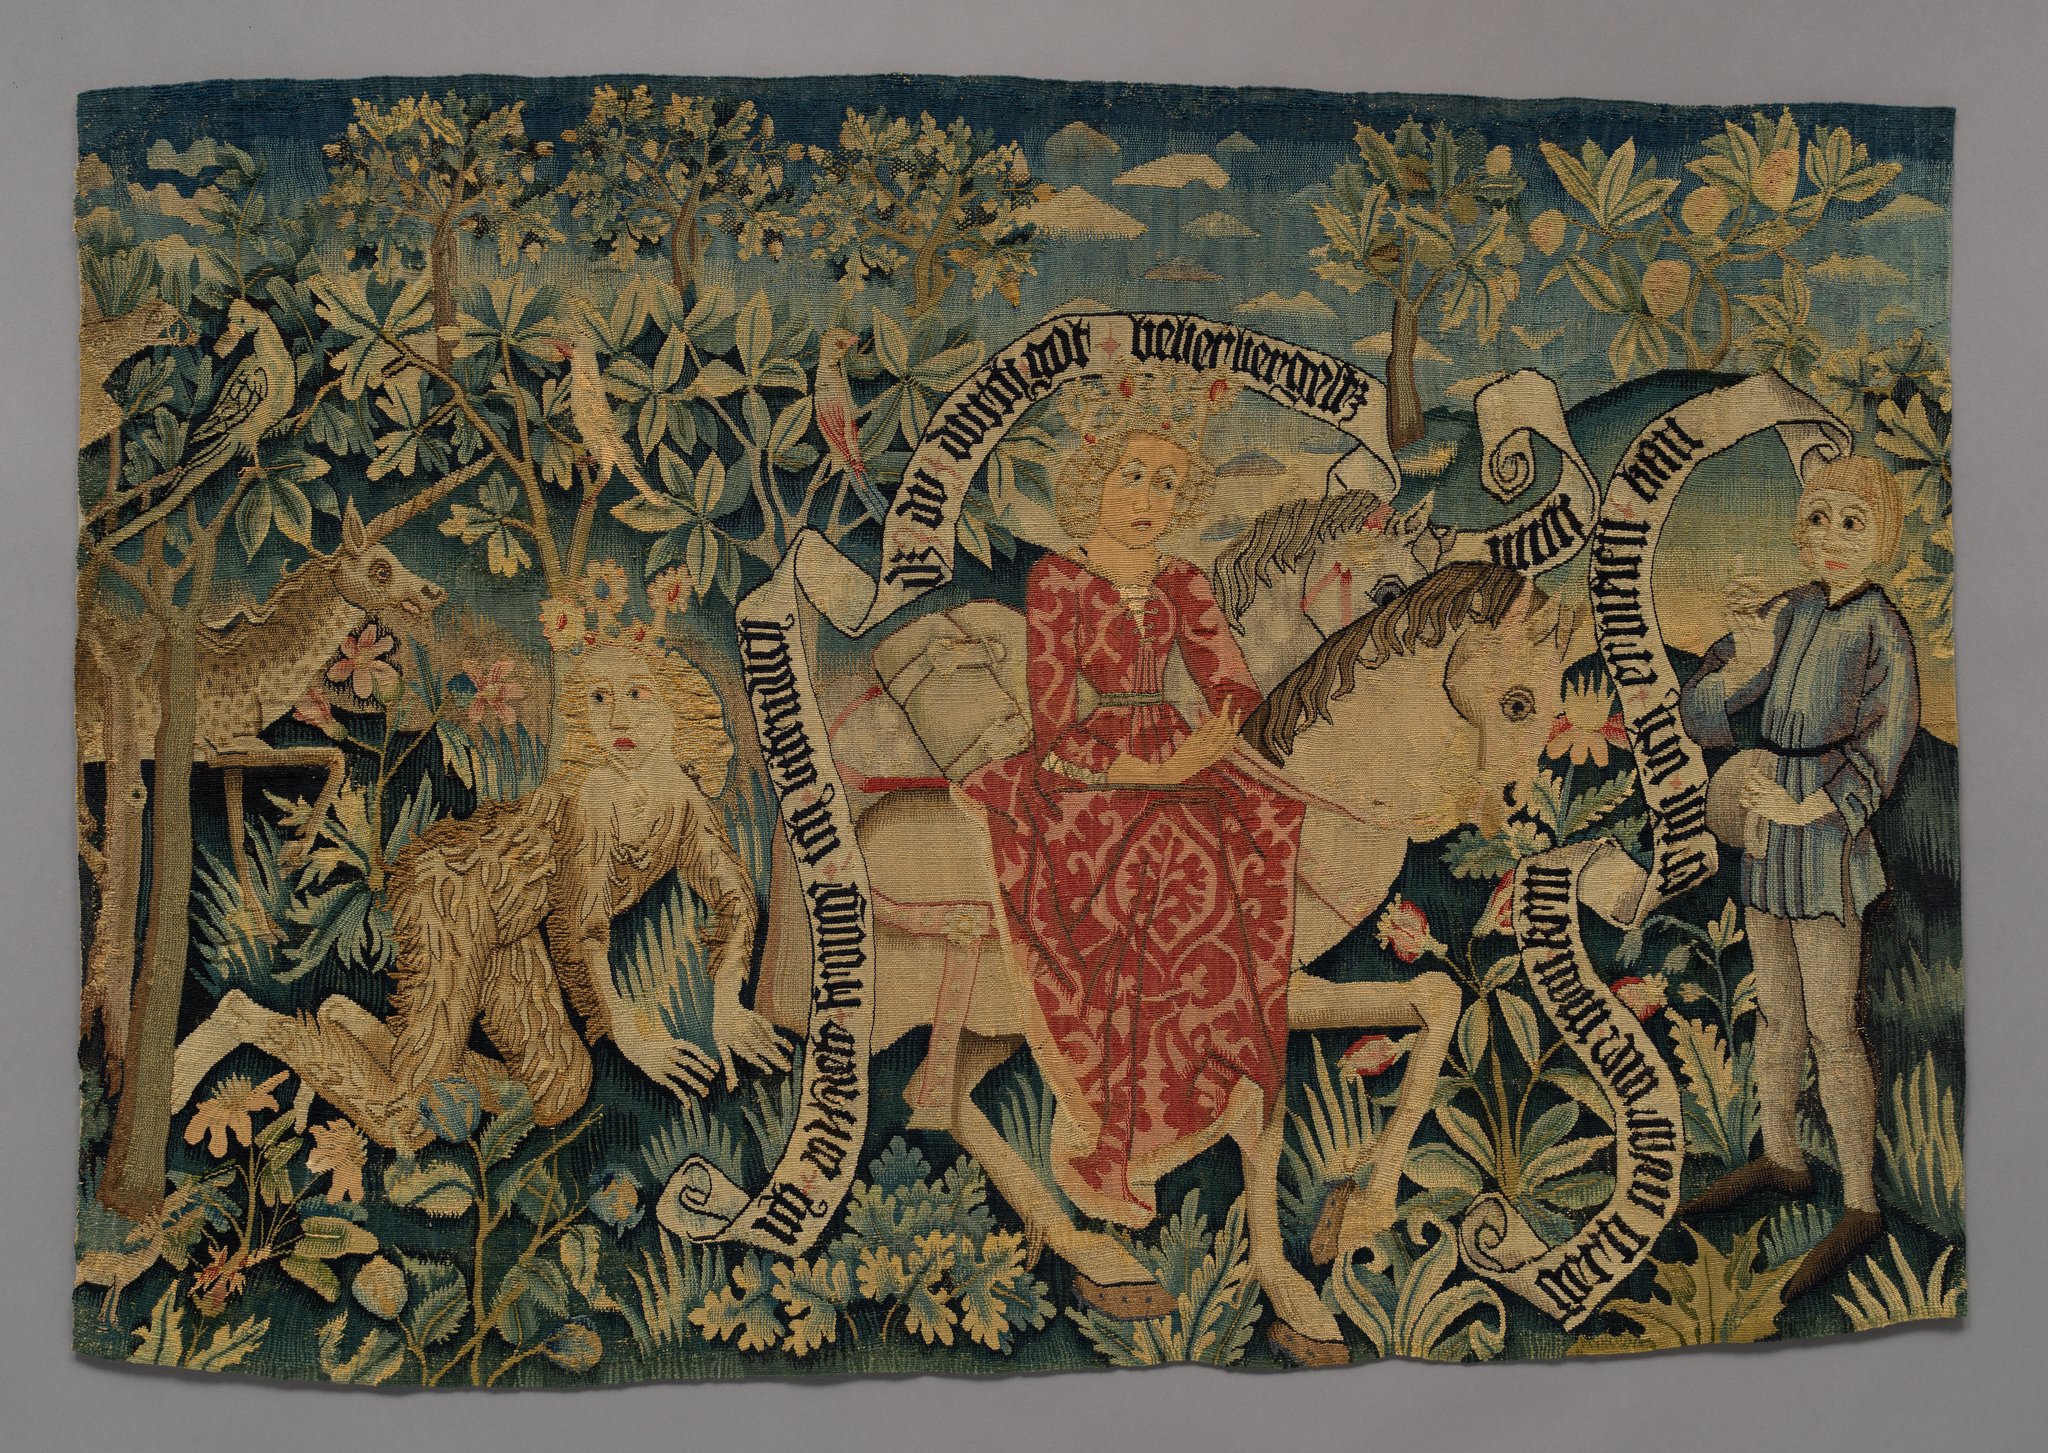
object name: fragment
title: Two Scenes from "Der Busant" (The Buzzard)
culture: upper rhenish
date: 1480-1490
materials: linen, silk, wool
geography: france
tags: birds,men,women,unicorns,horses